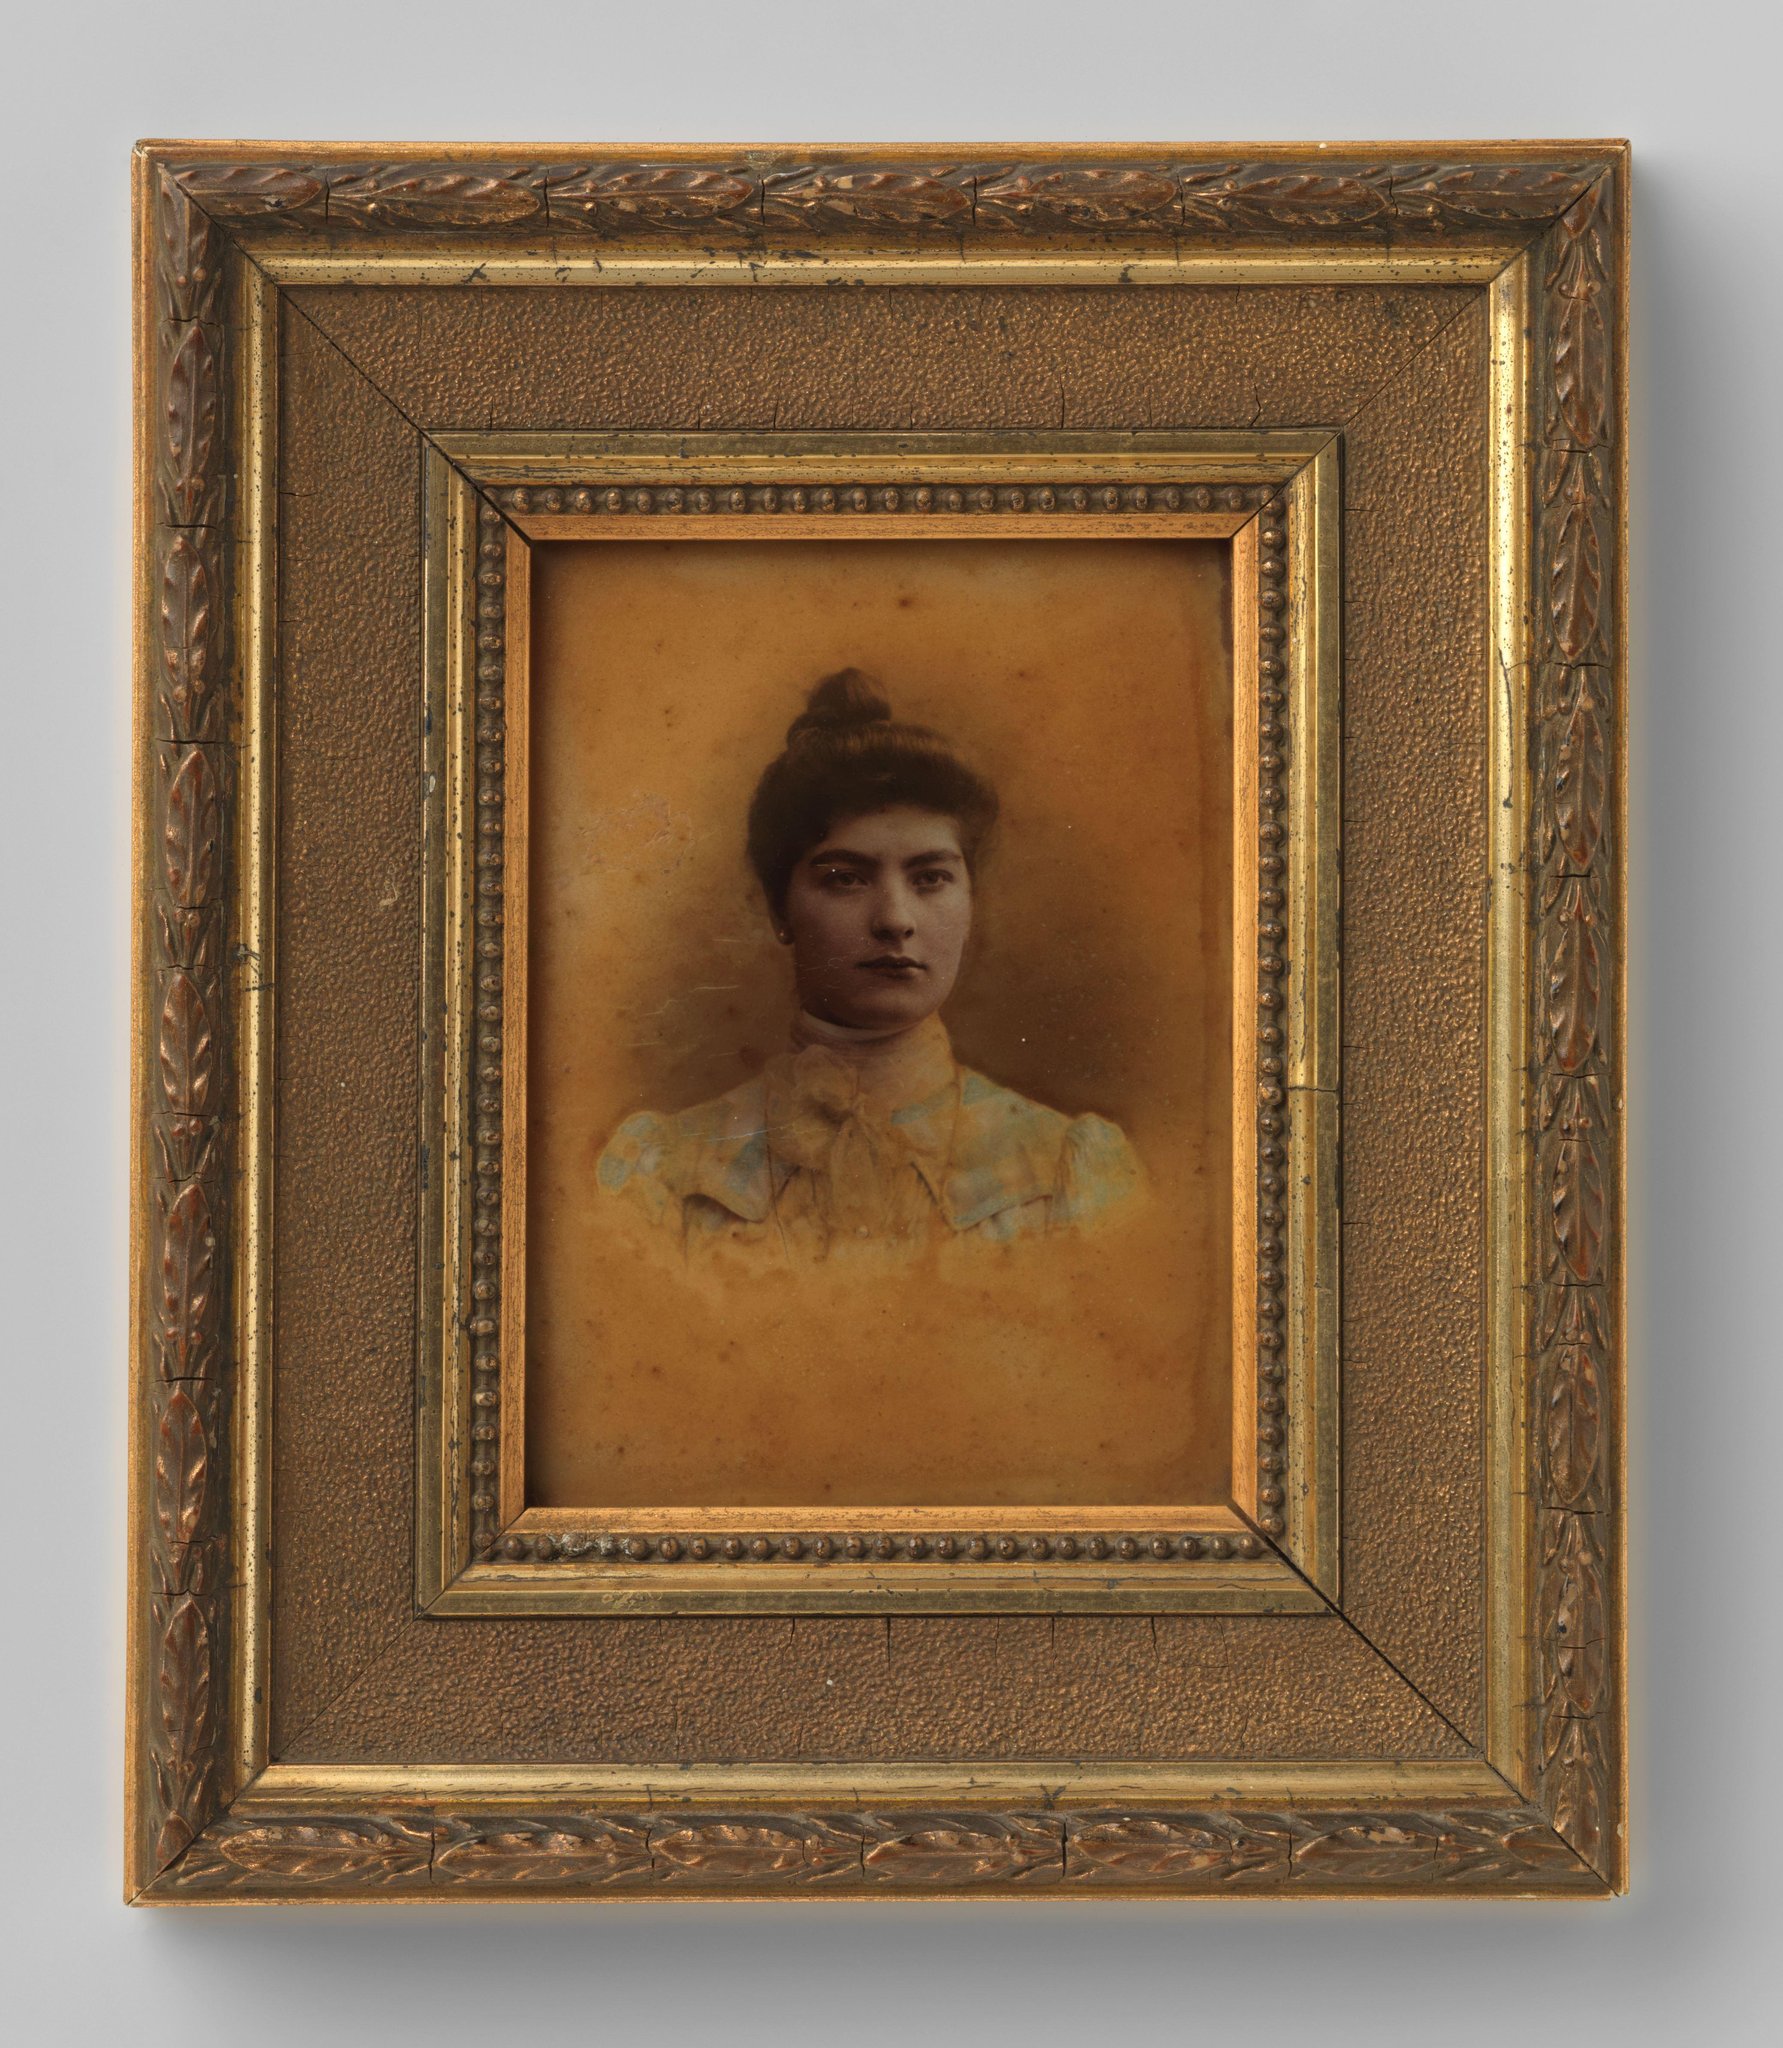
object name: crystoleum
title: Portret van een onbekende vrouw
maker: willem gerhardus kuijer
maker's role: fotograaf, hoffotograaf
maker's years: 1834-1899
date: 1890-1906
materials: cardboard, paint, glass, metal, paper, wood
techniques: albumen print, gilding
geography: amsterdam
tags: historical persons - bb - woman